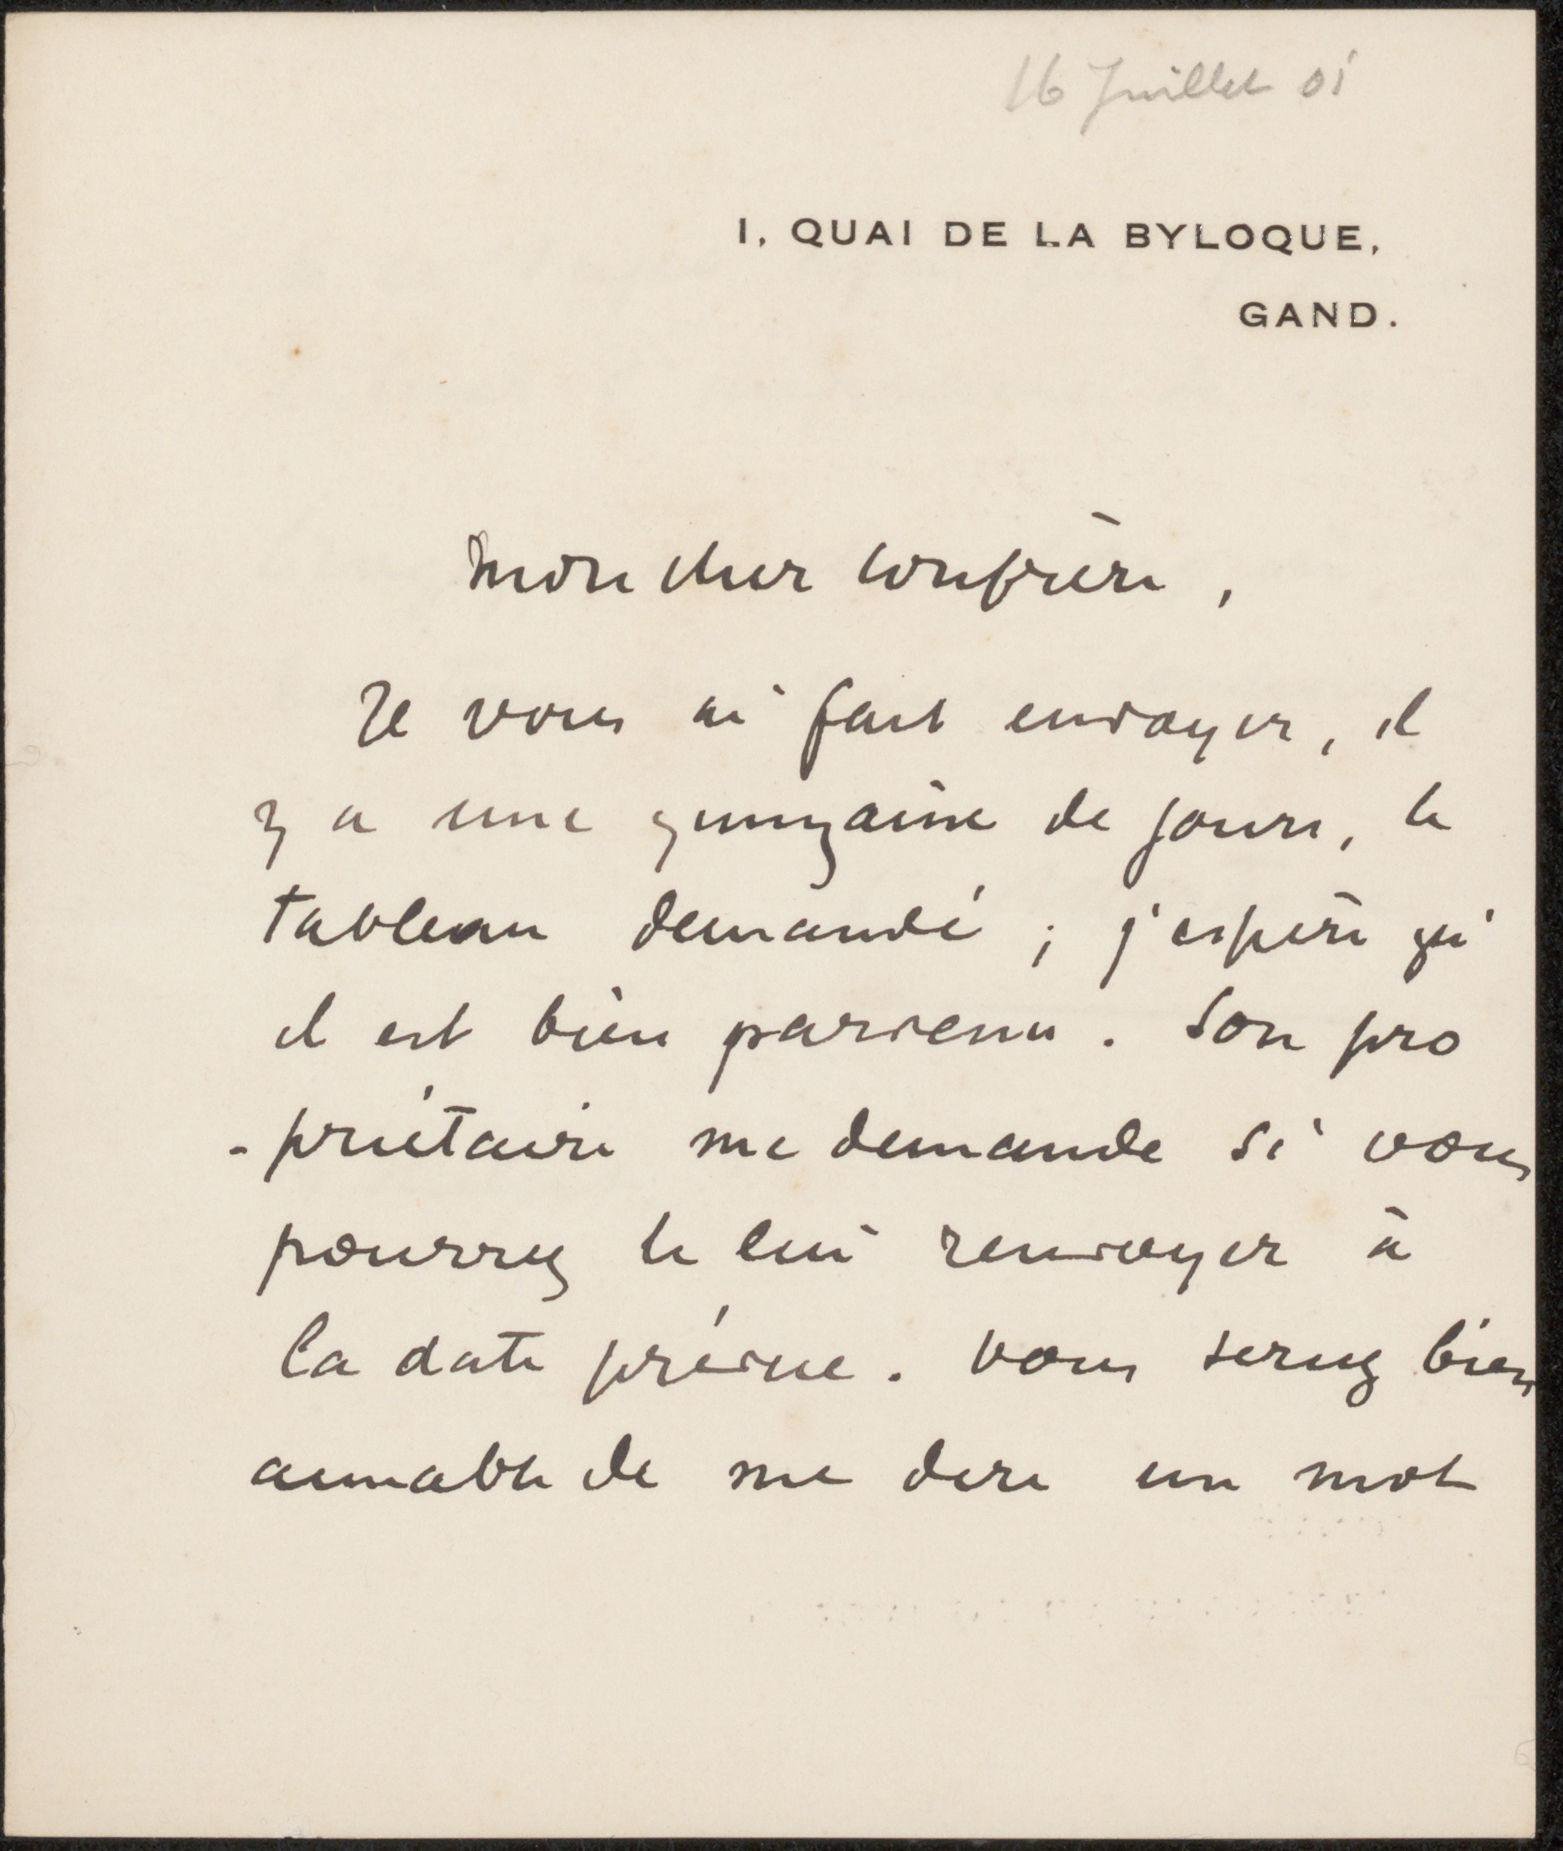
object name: letter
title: Brief aan Philip Zilcken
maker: albert baertsoen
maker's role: draughtsman, print maker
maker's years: 1866-1922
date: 1901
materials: ink, paper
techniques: pen, printing, writing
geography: ghent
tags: painter, draughtsman, philip zilcken, sending and receiving postal matter, painting (including book-illumination, miniature-painting)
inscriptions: collector's mark: ‘RPK’